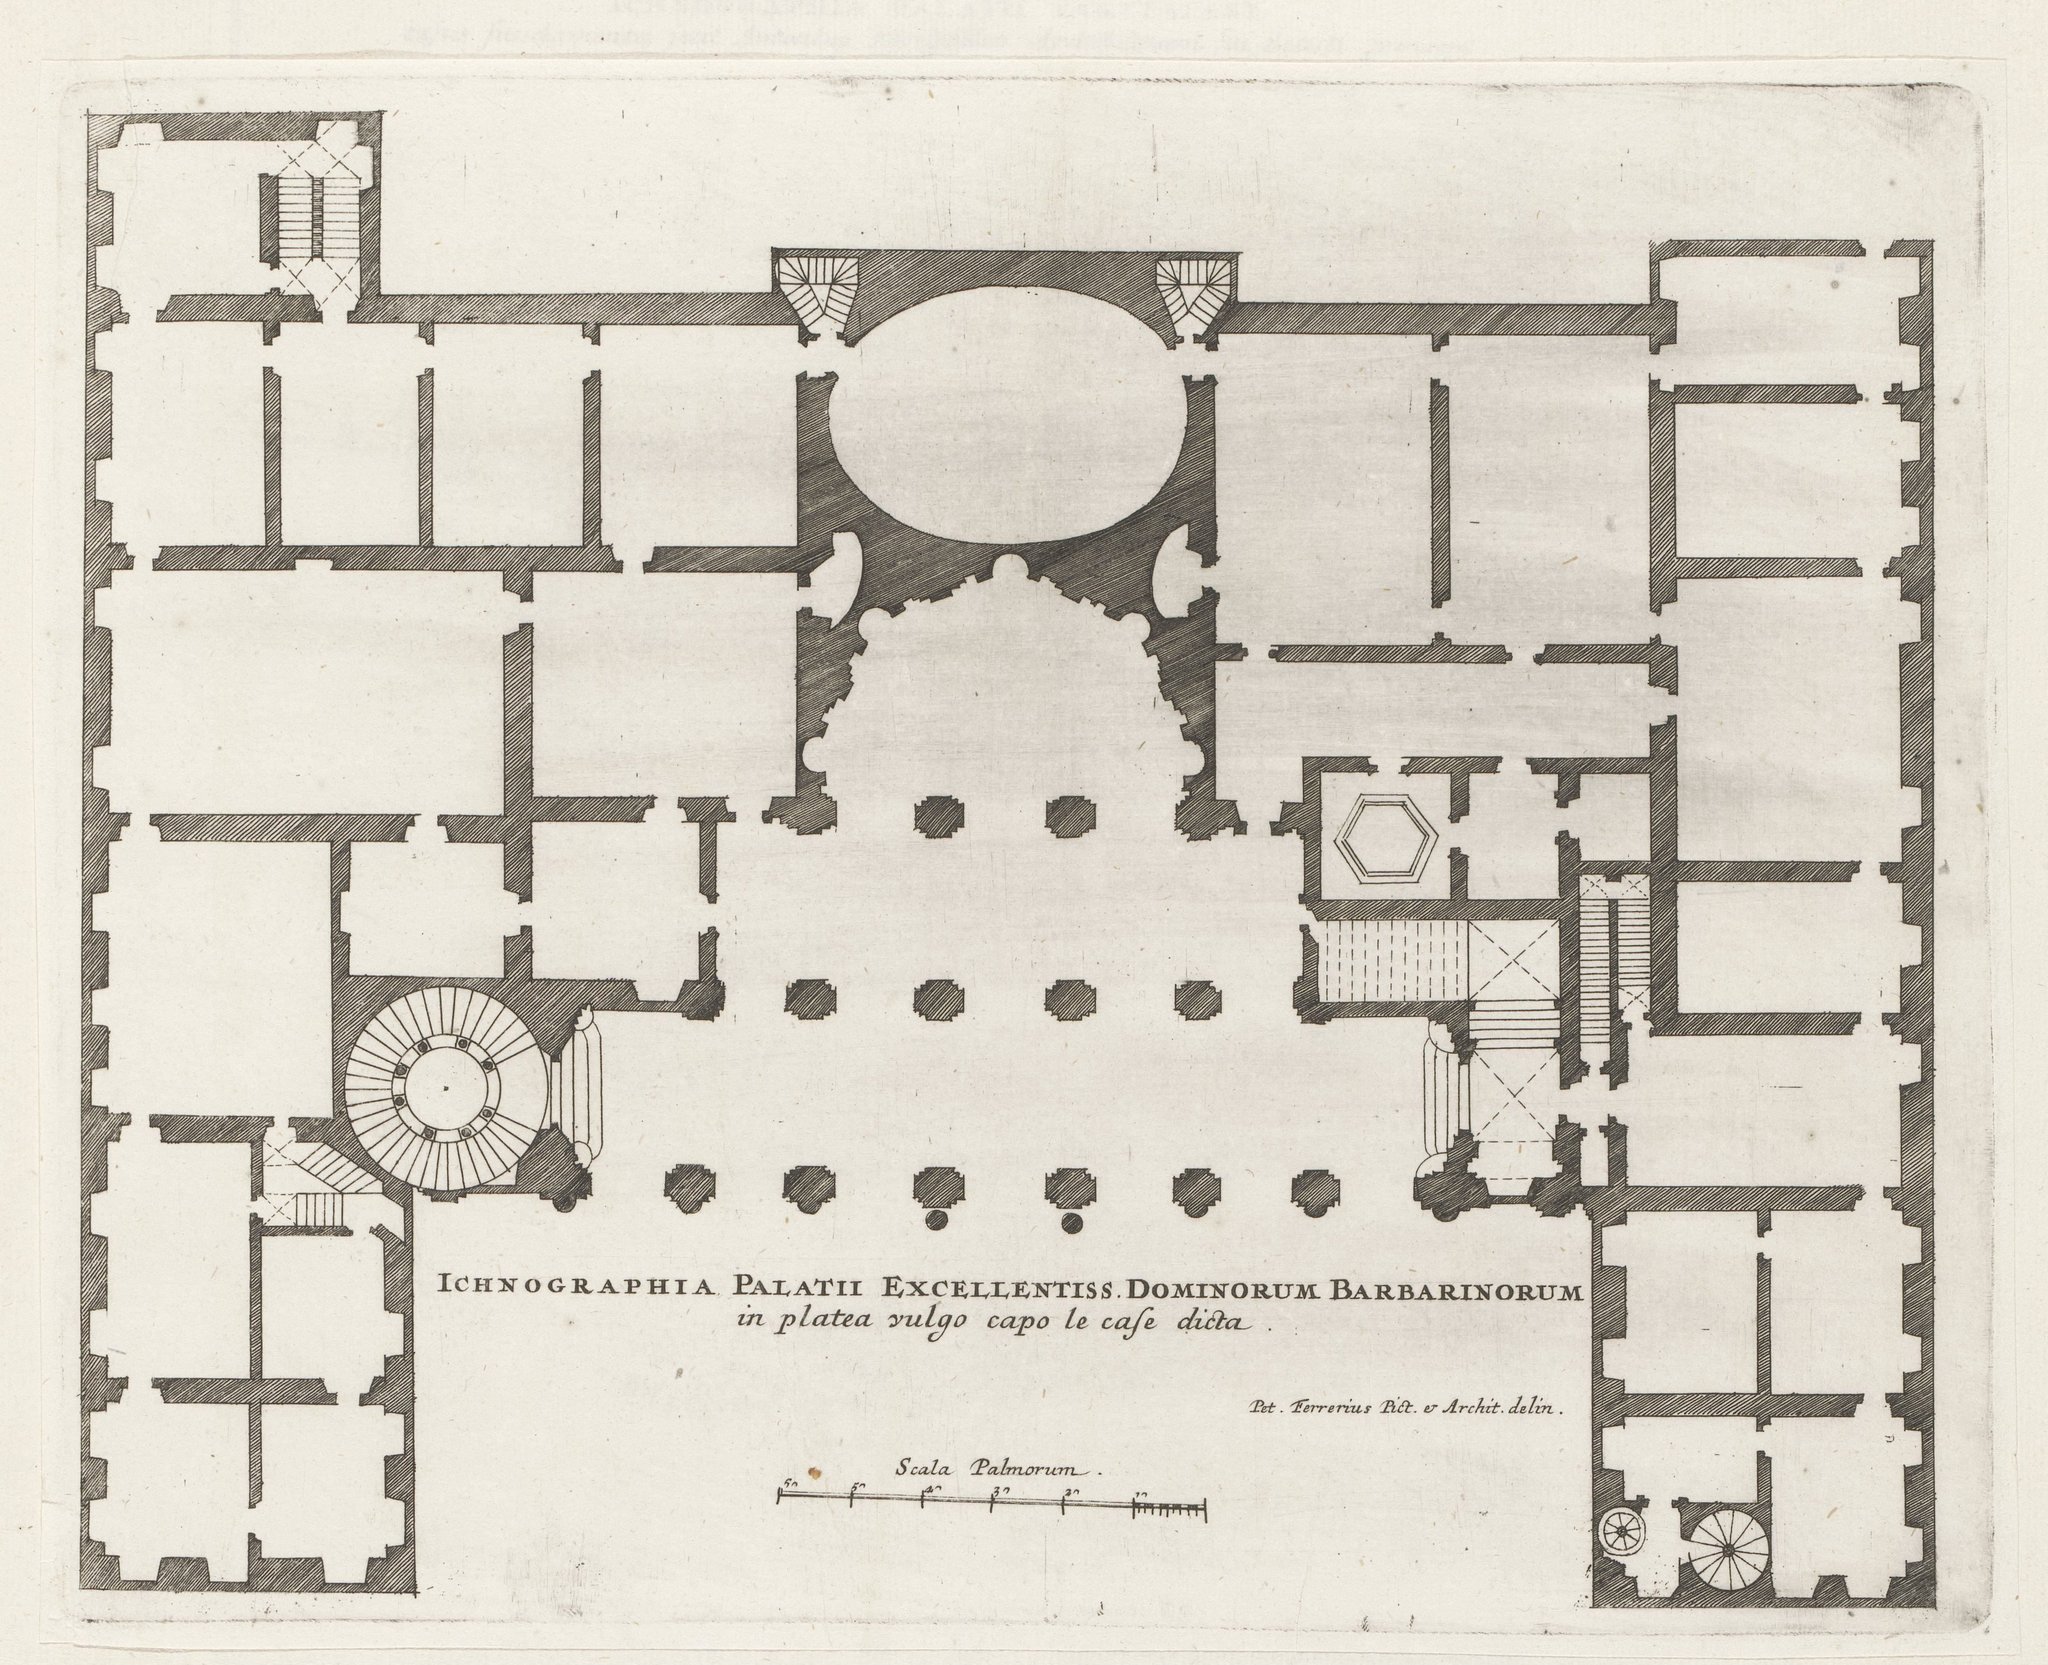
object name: print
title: Magesyn der Italiaense gebouwen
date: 1655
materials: paper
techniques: etching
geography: italy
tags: palace, plan ~ architecture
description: Deze prent maakt deel uit van de reeks getiteld: Palazzi di Roma. Deze reeks bestaat uit twee boeken. Boek één getiteld: Palazzi di Roma dei più celebri architetti..., bestaat uit 44 prenten die worden toegeschreven aan Giovanni Battista Falda (naam staat enkel op prent 27) en uitgegeven door Giovanni Giacomo de'Rossi. Deze 44 prenten zijn bekend in twee staten (met en zonder nummer). Boek twee getiteld: Nuovi disegni dell'architetture... libro secondo, bevat 66 prenten door Giovanni Battista Falda en Simone Felice. Deze 66 prenten zijn bekend in twee staten (met en zonder nummer).